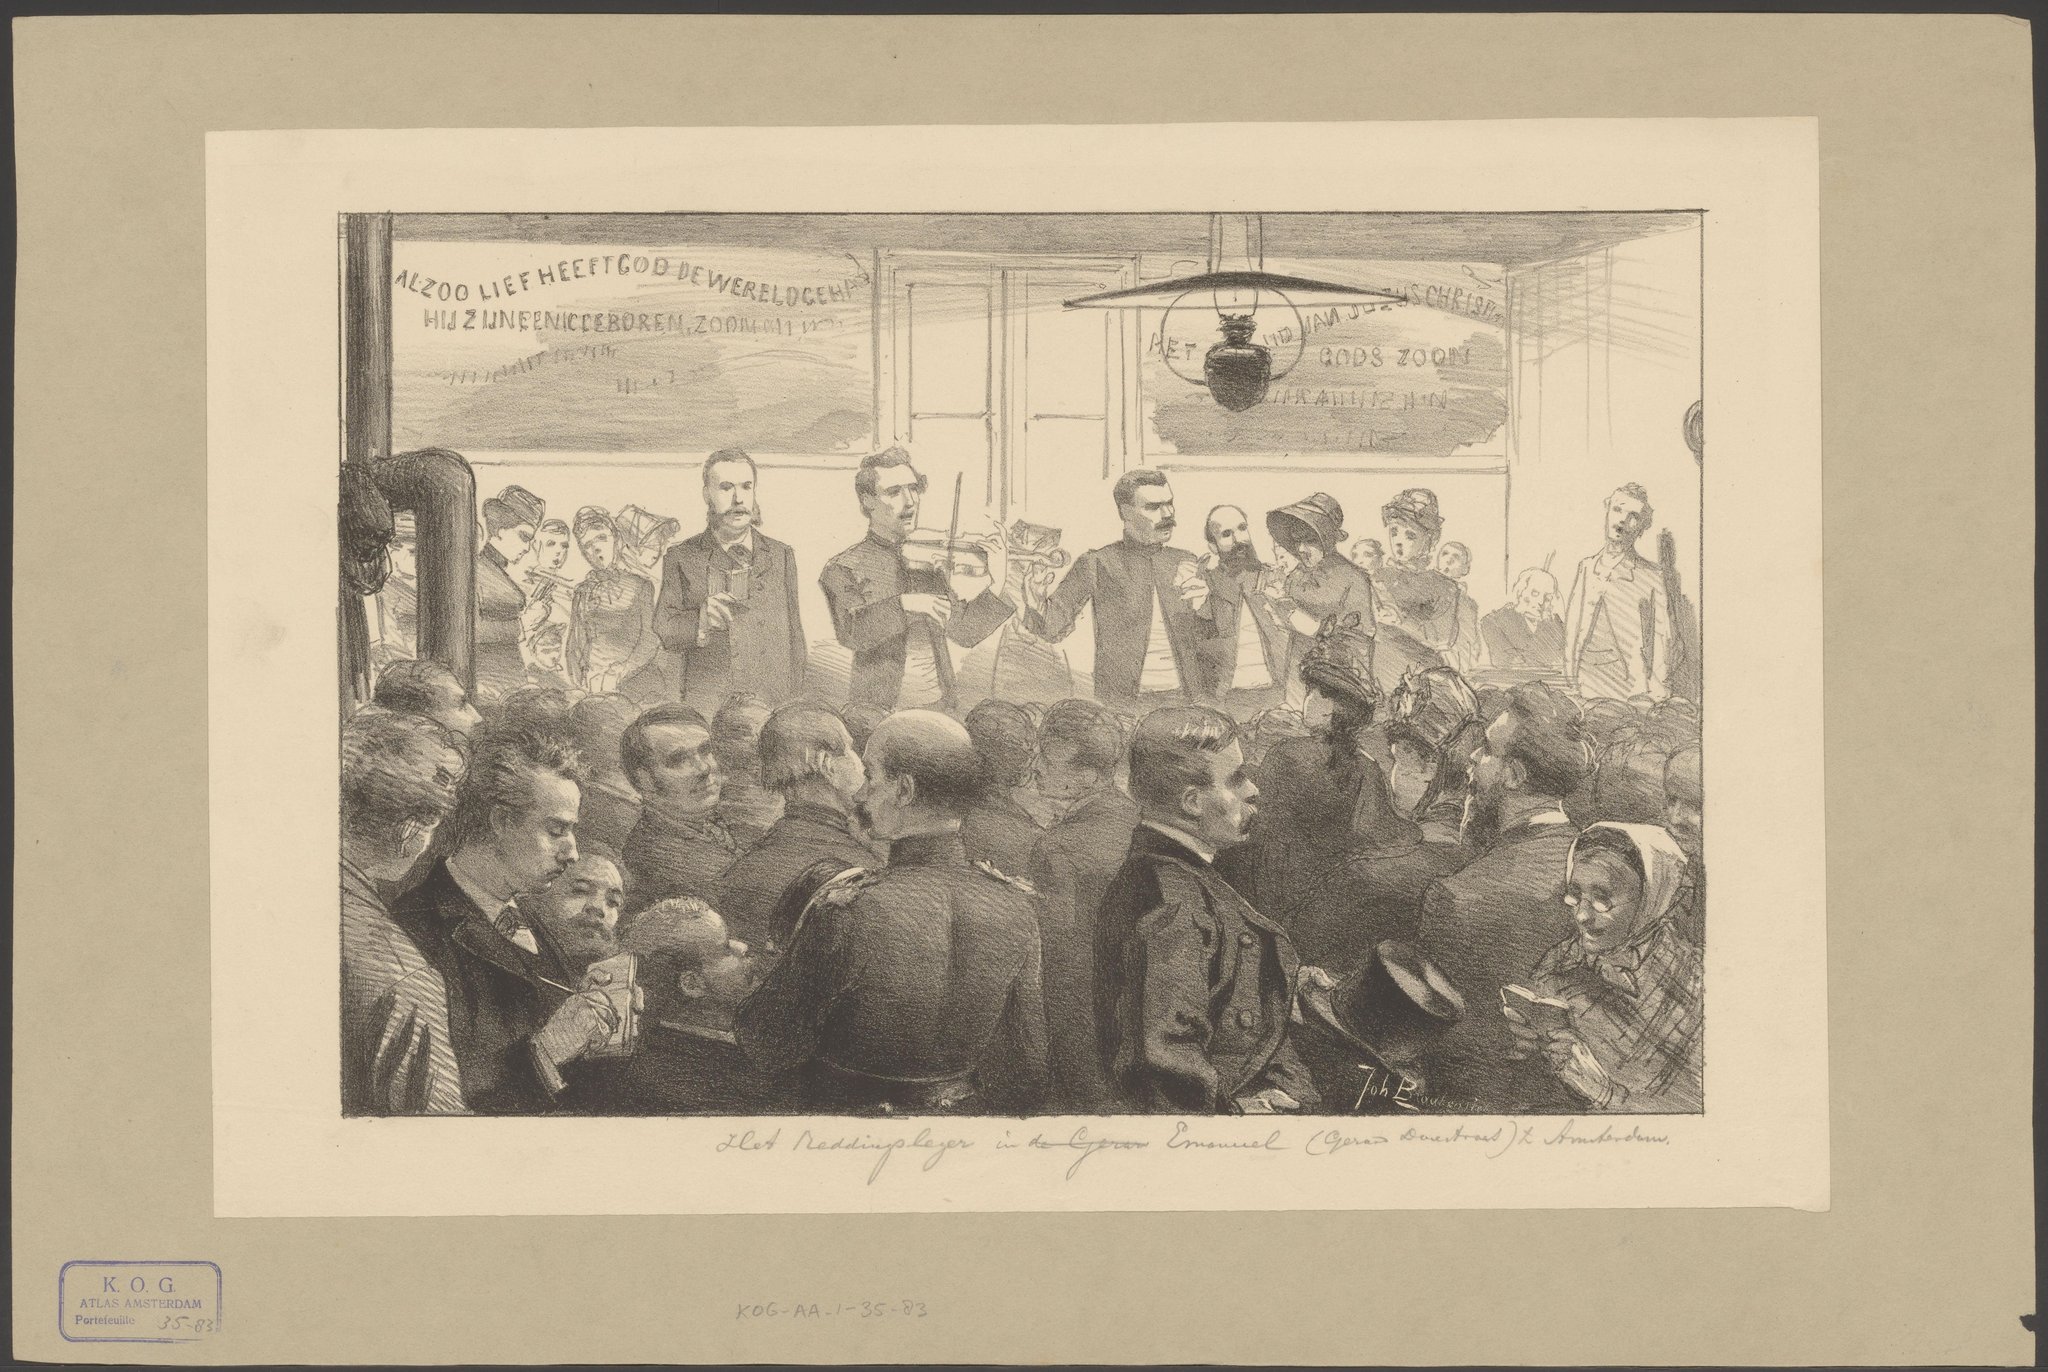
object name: print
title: Bijeenkomst van het Leger des Heils in de volkszaal Emmanuël in de Gerard Doustraat te Amsterdam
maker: johan braakensiek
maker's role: draughtsman, print maker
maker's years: 1858-1940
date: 1887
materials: paper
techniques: lithograph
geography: amsterdam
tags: assembly-room, the synagogue (as building and place of worship ~ jewish religion), salvation army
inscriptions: collector's mark: ‘35-83’ Lugt 1641b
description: Onderwerpsrubriek binnen de Atlas Amsterdam: R.K. Gemeenten: Leger des Heils.